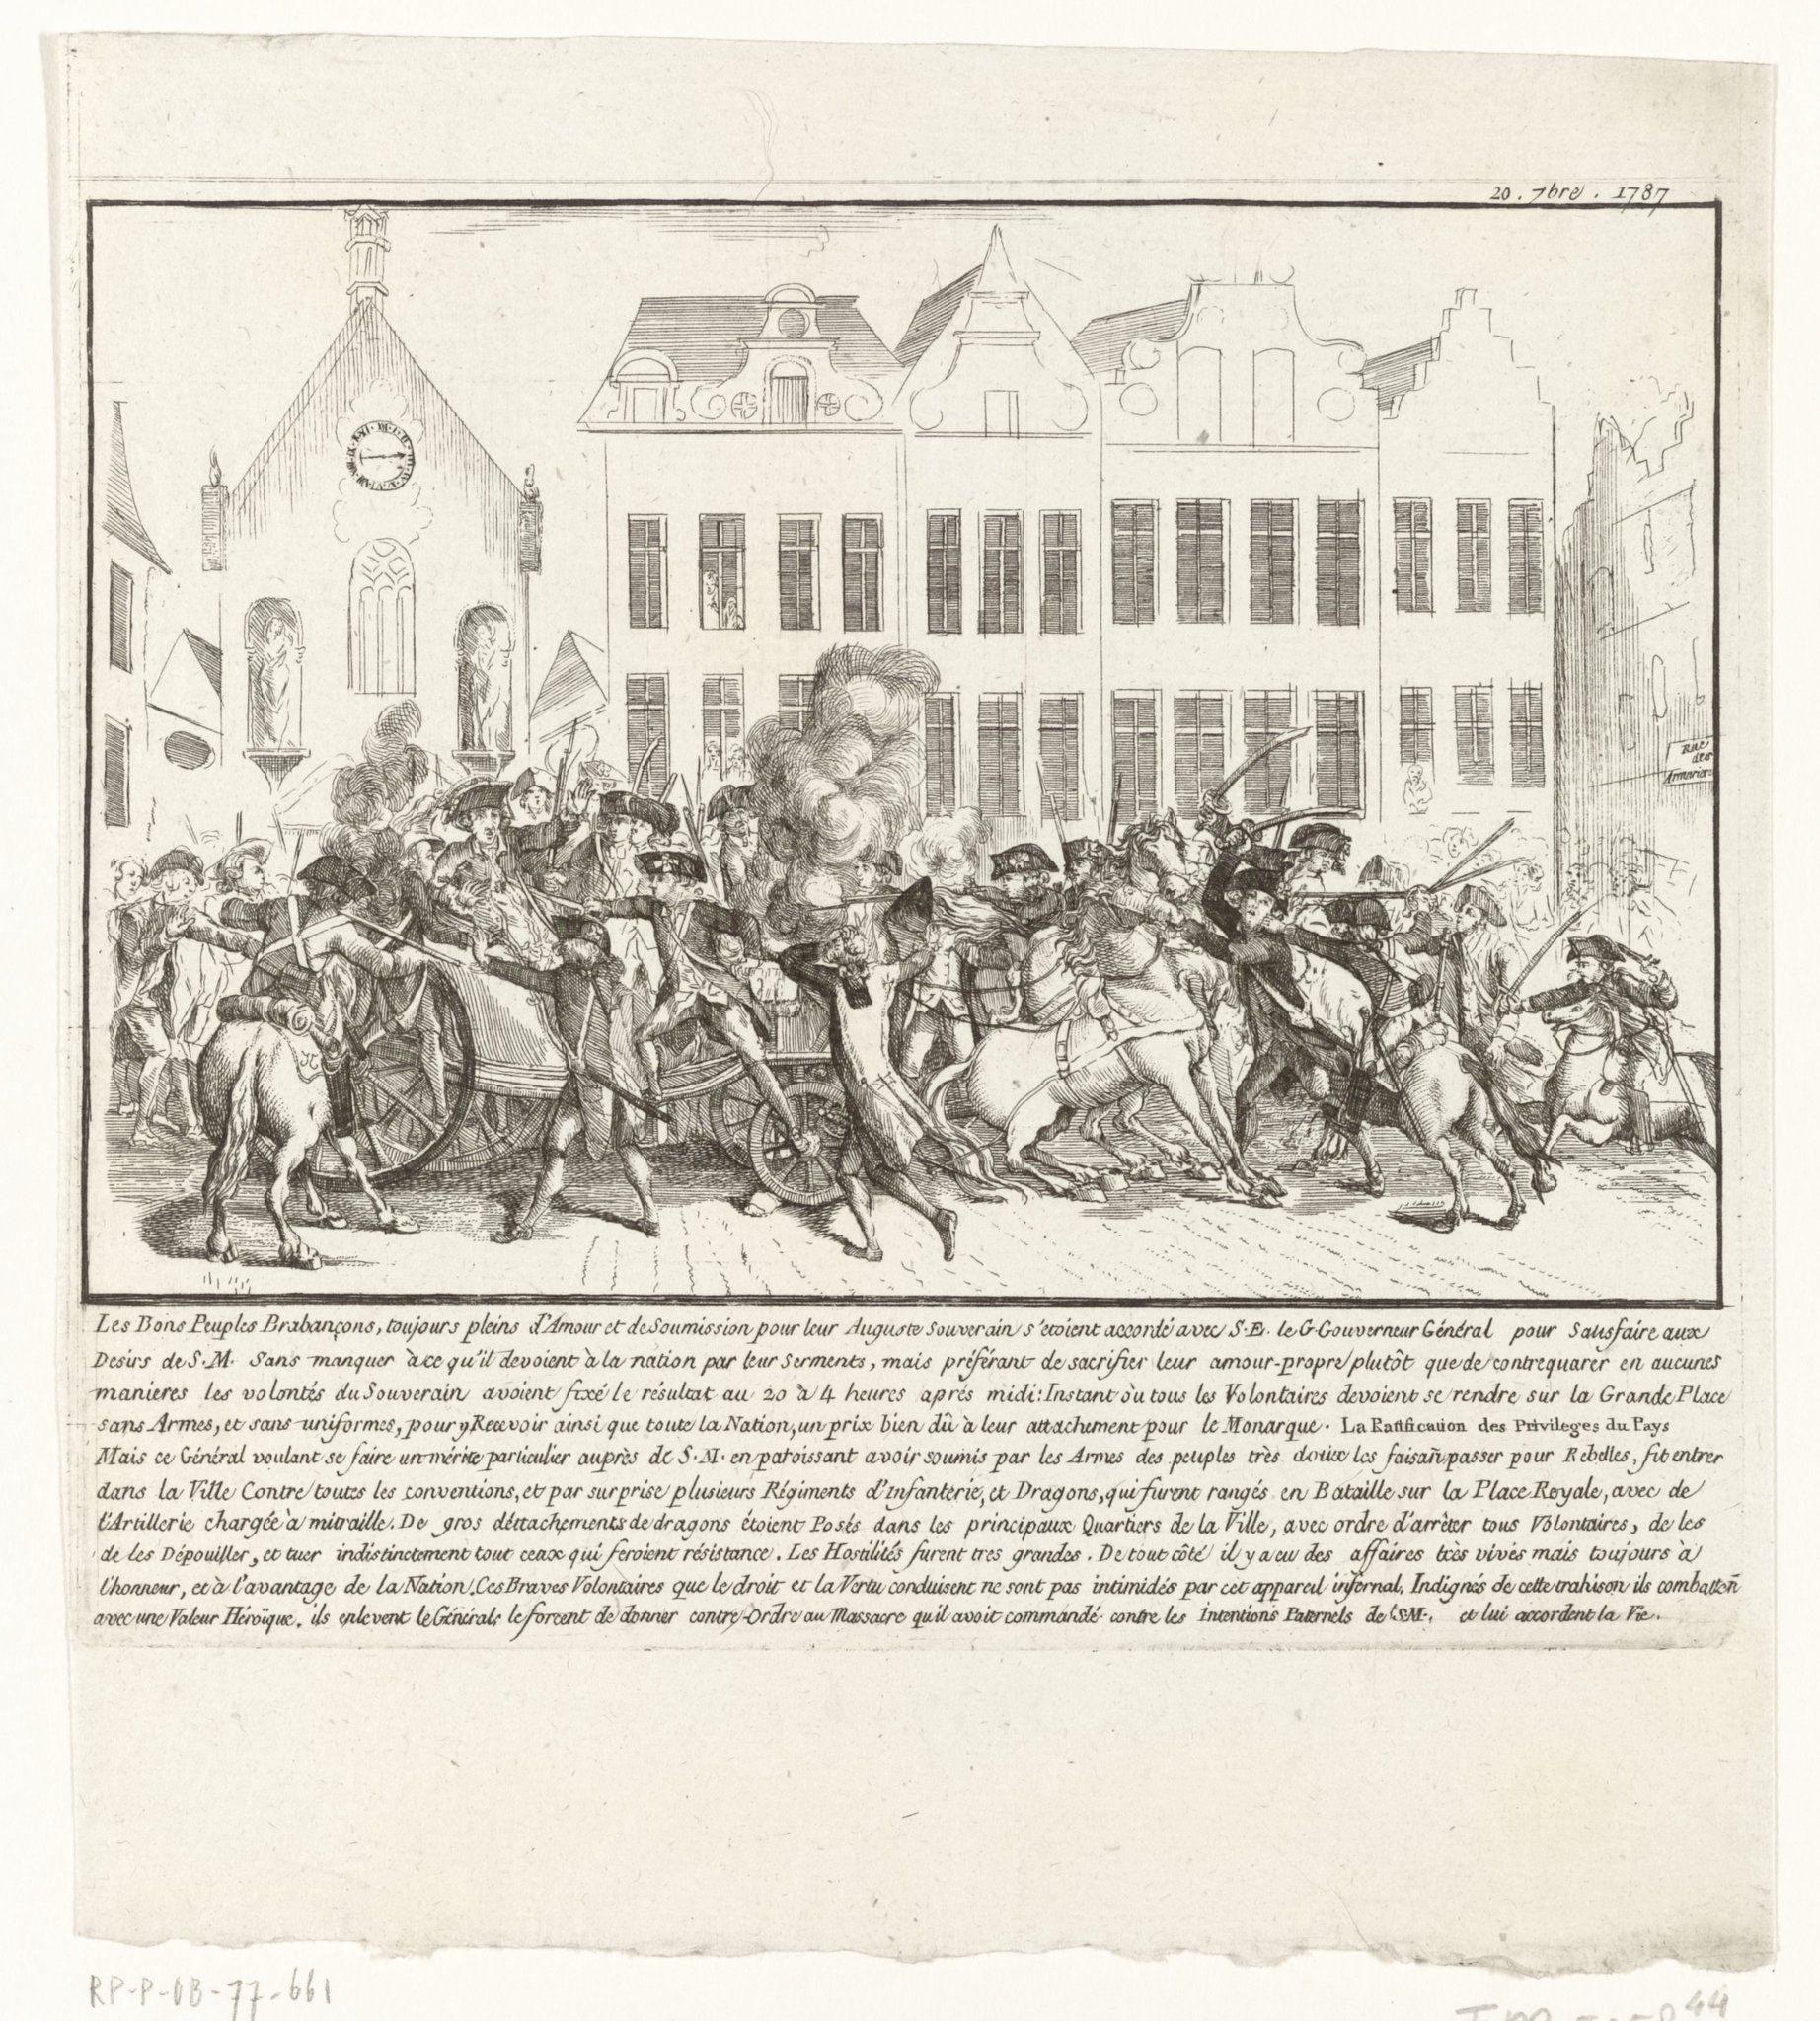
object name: print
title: Rijtuig met generaal d'Alton aangevallen te Brussel, 1787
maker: Anonymous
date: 1787-1790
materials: paper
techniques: engraving, etching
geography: southern netherlands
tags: street-fights, riots, brabant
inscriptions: collector's mark: Lugt 2228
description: Het rijtuig met generaal d'Alton wordt aangevallen door woedende vrijwilligers, op de Grote Markt te Brussel, 20 september 1787. Met onderschrift van 10 regels in het Frans. Onderdeel van een grote groep van prenten betrekking hebbend op de gebeurtenissen van de Brabantse Omwenteling en de periode 1787-1790.